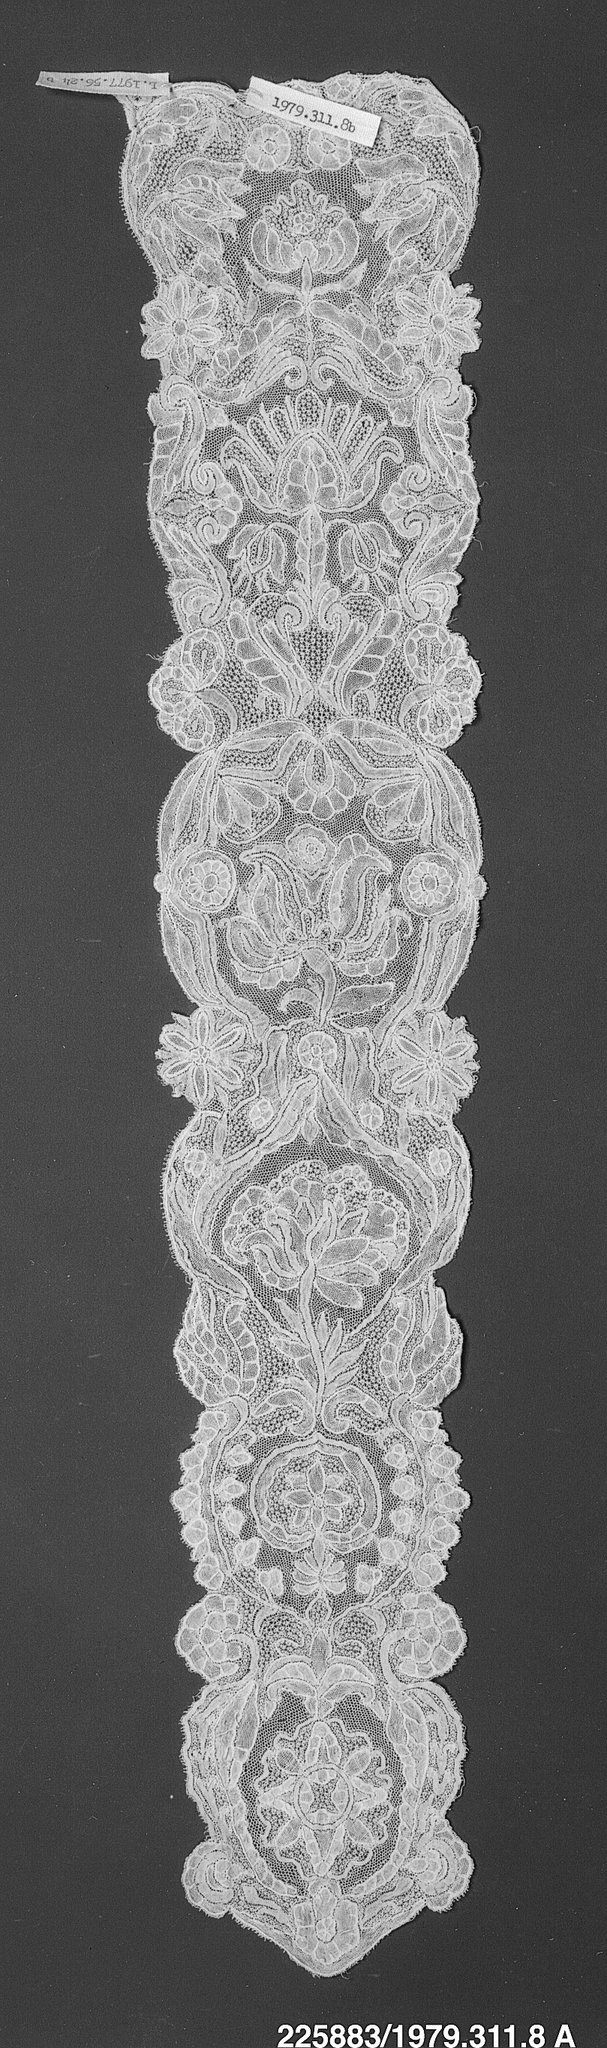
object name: lappet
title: Lappets (2)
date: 1734-1766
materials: linen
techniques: lace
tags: flowers